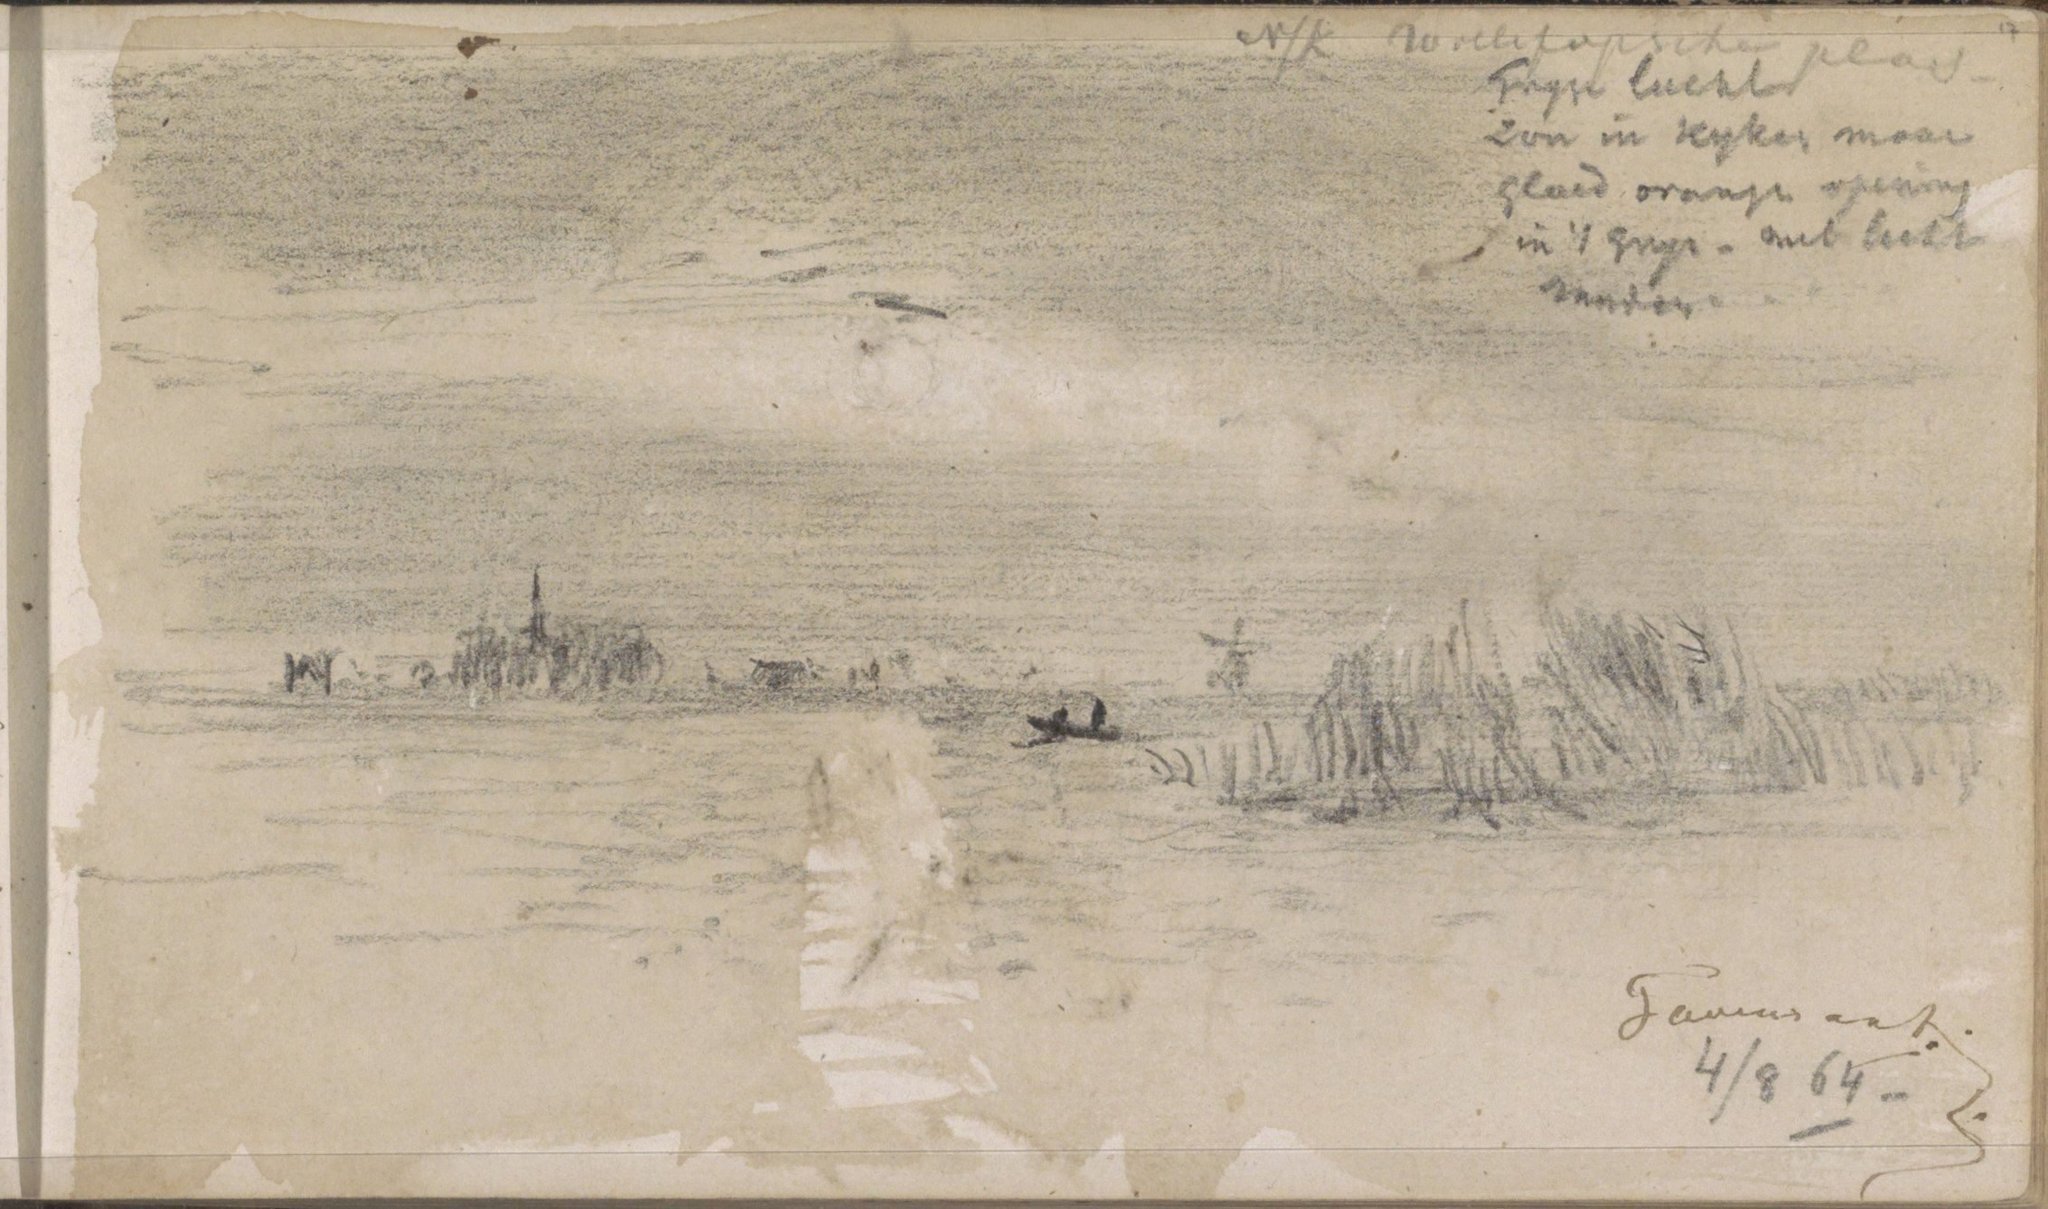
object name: sketchbook leaf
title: Gezicht op de Wollefopse Plas bij Rotterdam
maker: johannes tavenraat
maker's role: draughtsman, painter, print maker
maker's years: 1809-1881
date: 1808-1864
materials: ink, paper, pencil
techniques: brush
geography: rotterdam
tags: landscapes with waters, waterscapes, seascapes (in the temperate zone), windmill in landscape, rotterdam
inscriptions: date and inscription: ‘N/K Wollefopsche Plas/ [...]/ 4/8 64-’, signature: ‘Tavenraat’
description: Blad 17 recto uit een schetsboek met 98 bladen.